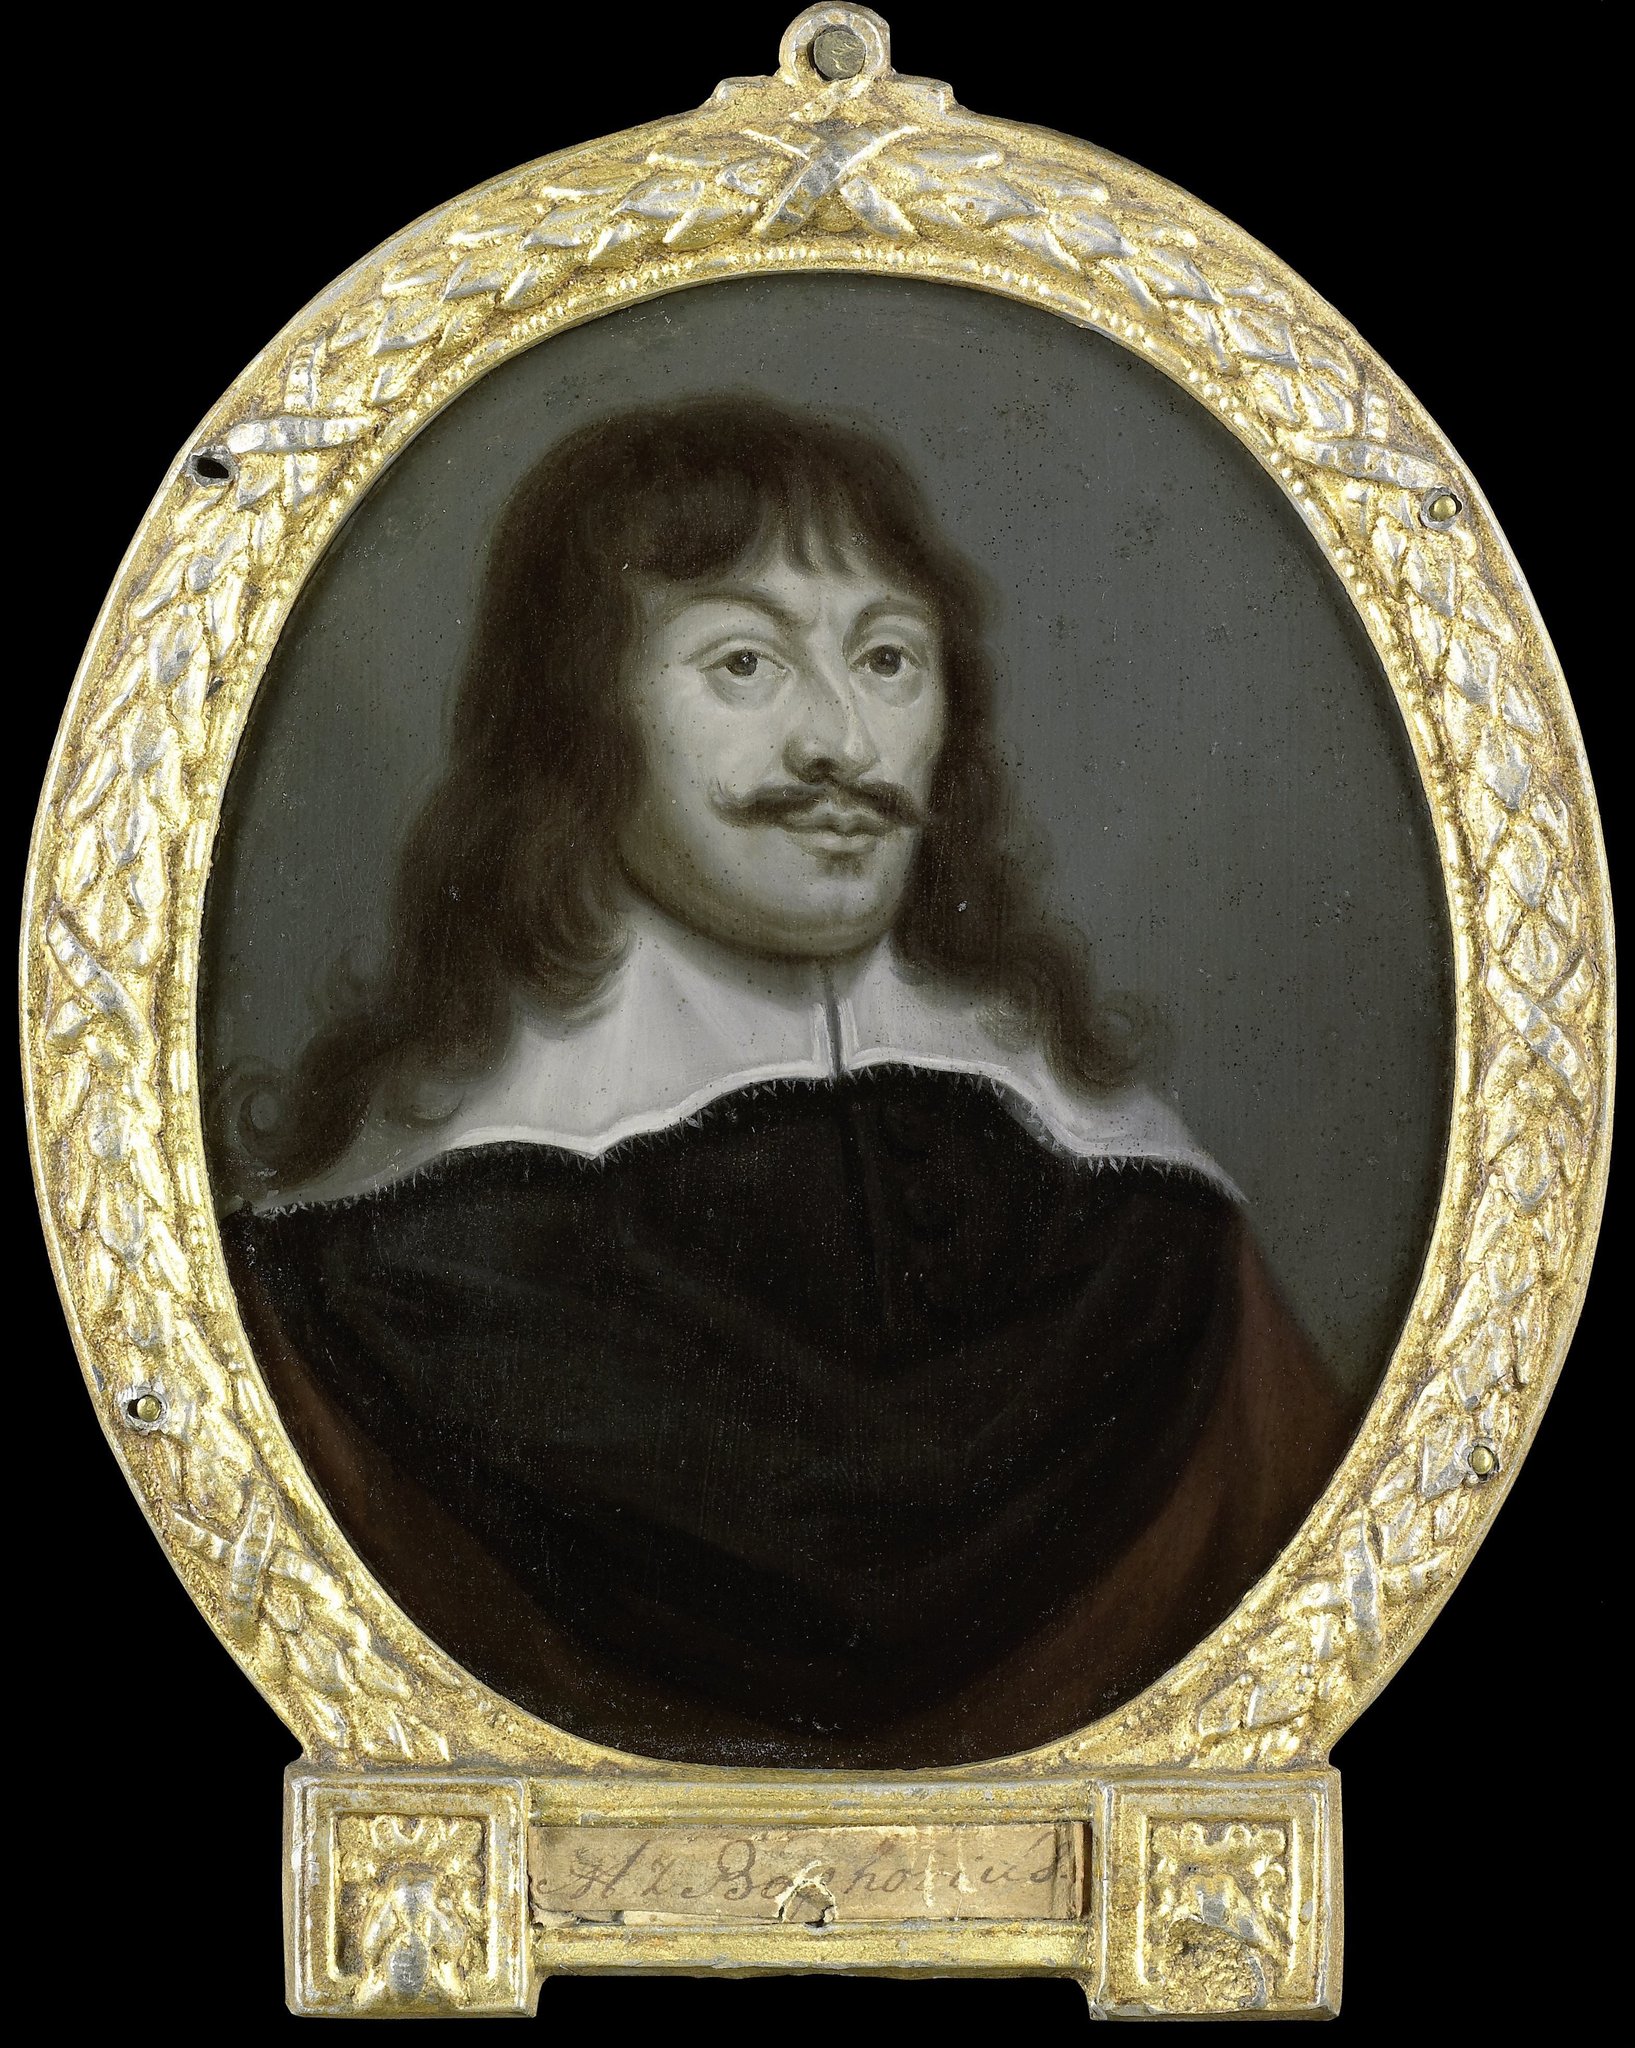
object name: painting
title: Portrait of Marcus Zuërius van Boxhorn, Historian and Professor at Leiden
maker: arnoud van halen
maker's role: draughtsman, painter, print maker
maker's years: 1673-1732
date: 1700-1732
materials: oil, metal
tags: leiden, marcus zuerius boxhorn, portrait of a writer, writer, poet, author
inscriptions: inscription: ‘Marcus Zweri Boxhornius 1612’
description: Portret van Marcus Zuerius Boxhorn (1612-53). Geschiedschrijver en hoogleraar te Leiden. Buste in ovaal, naar rechts. Onderdeel van een verzameling portretten van Nederlandse dichters.